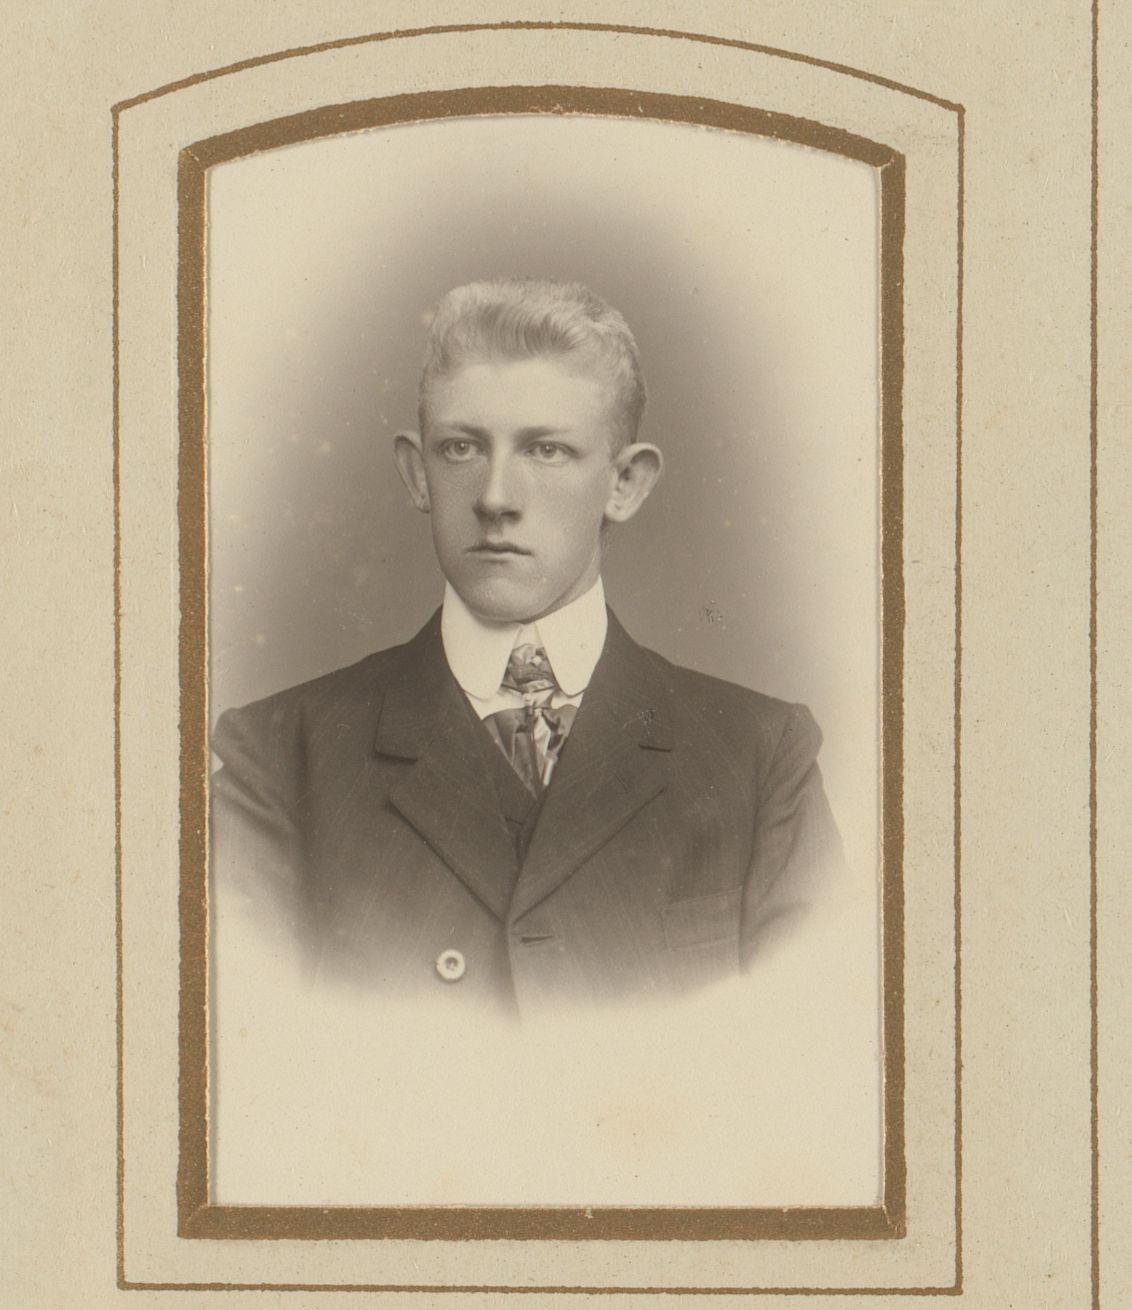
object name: album leaf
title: Portret van een jonge man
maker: e. van der aa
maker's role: fotograaf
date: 1880-1920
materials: cardboard, photographic support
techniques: collodion silver print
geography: purmerend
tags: historical persons, youth, adolescent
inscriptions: inscription: ‘E. van der Aa/ Koemarkt 115./ Purmerend.’